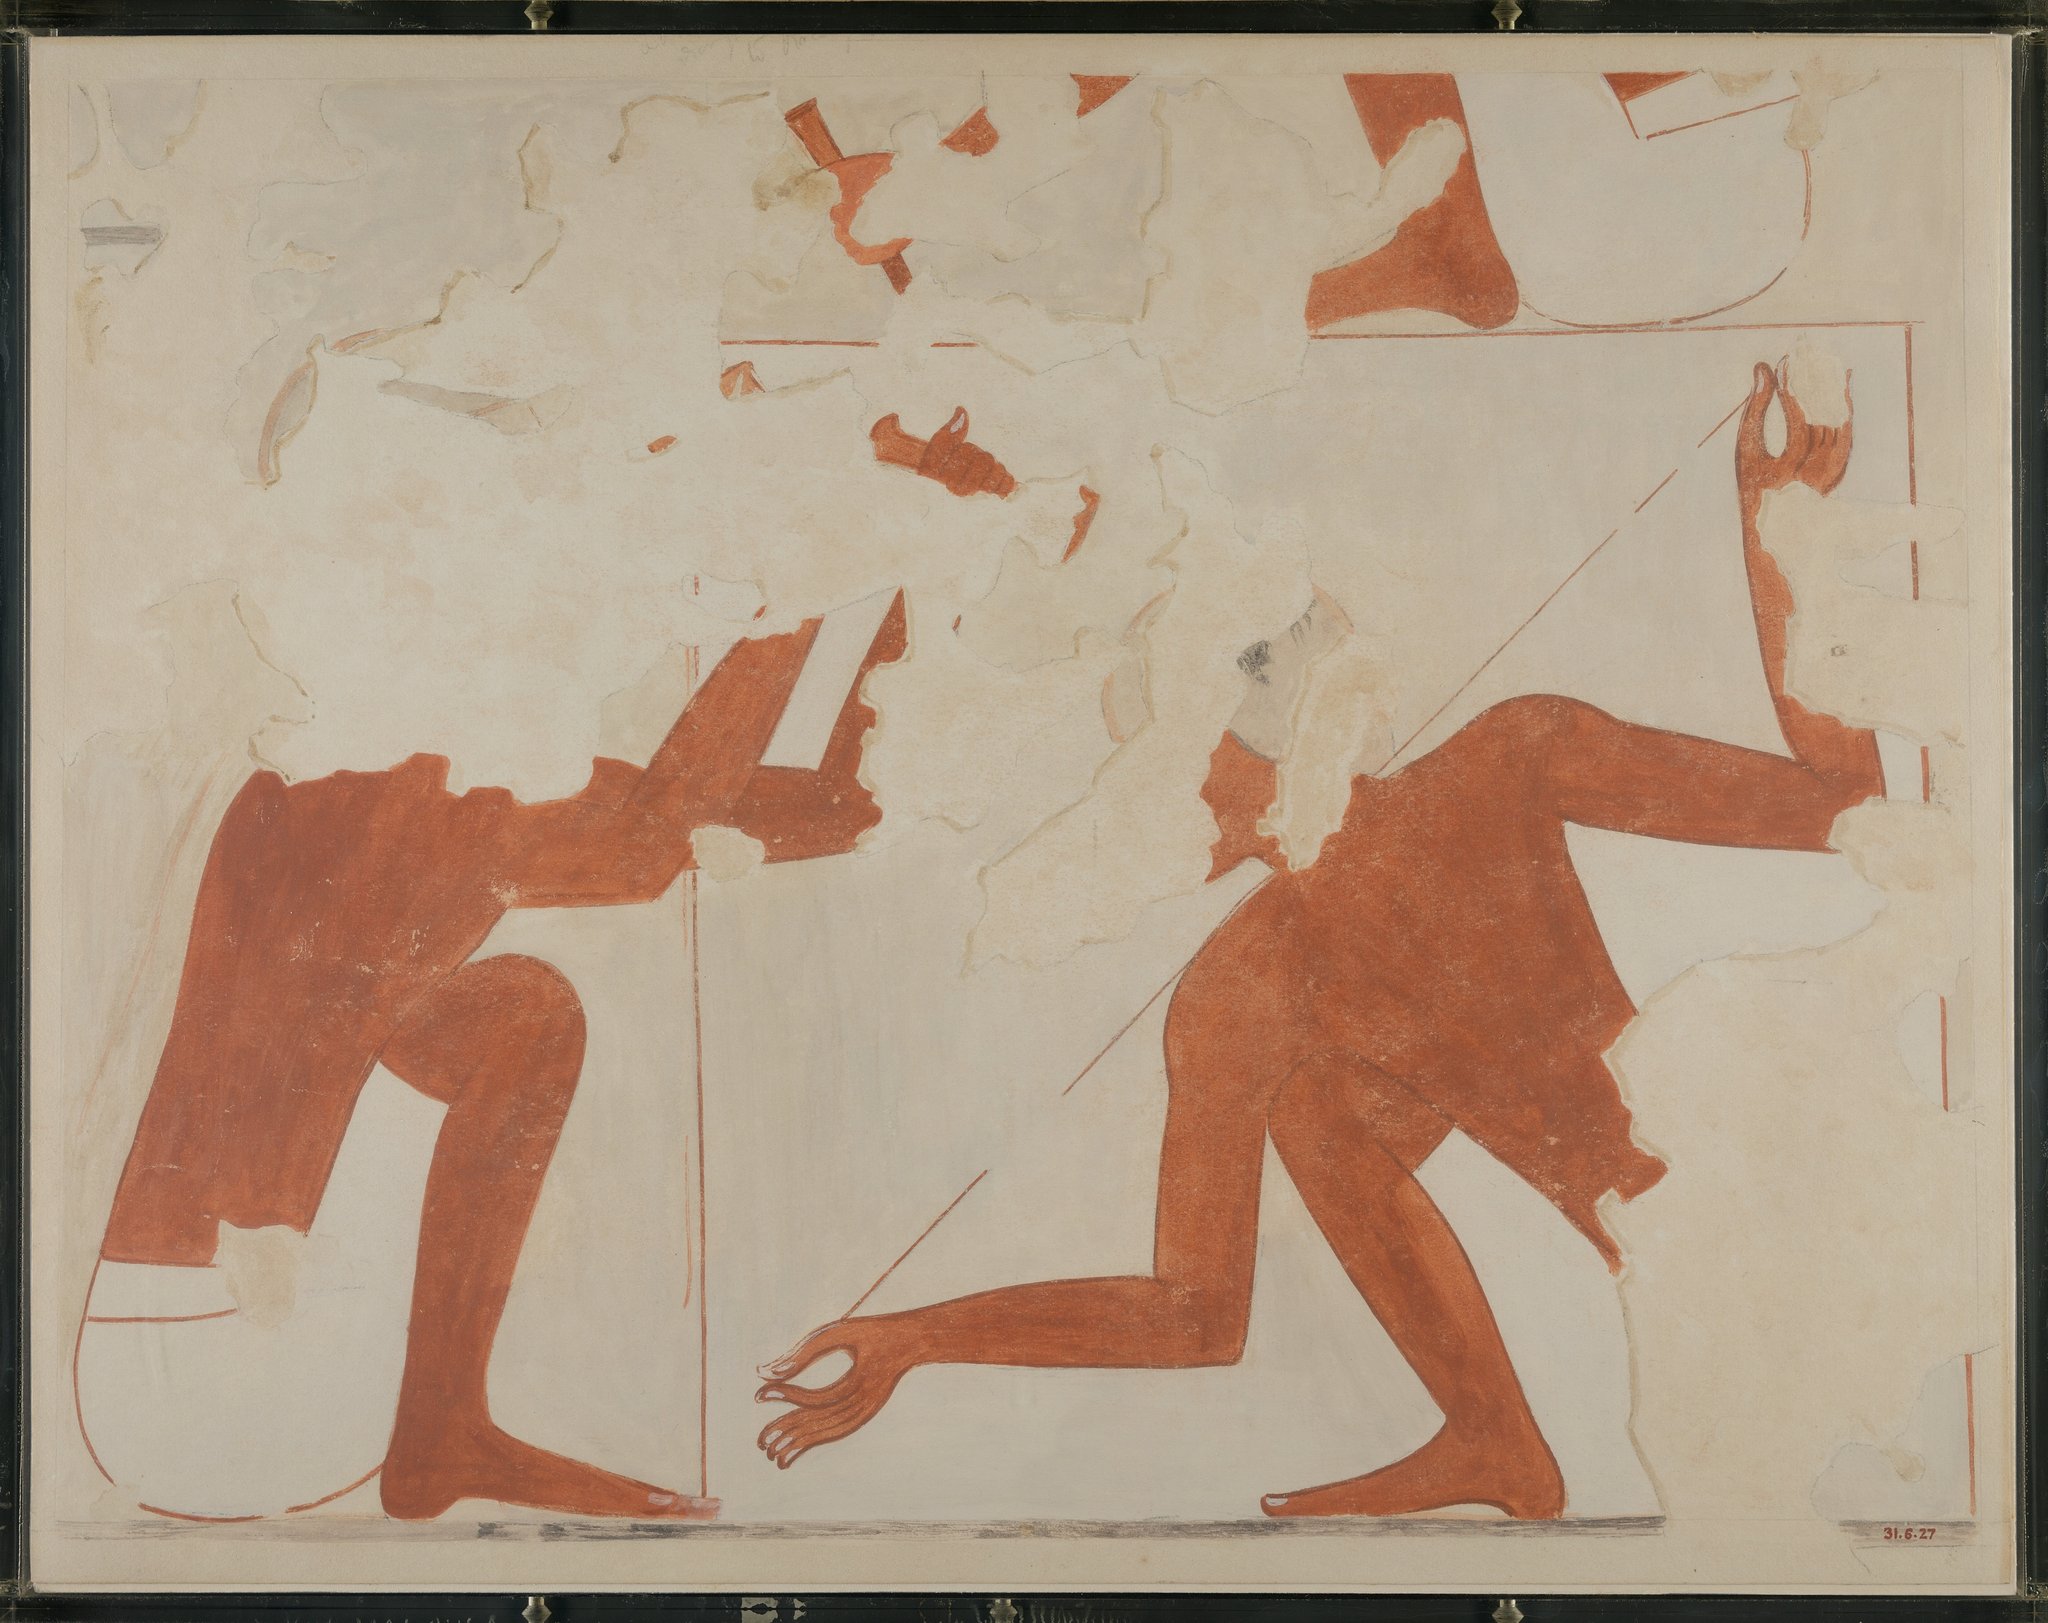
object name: facsimile, rekhmire tt 100, stone mason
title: Stone Masons Sqaring a Block, Tomb of Rekhmire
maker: nina de garis davies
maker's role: artist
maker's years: 1881-1965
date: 1504-1425 BCE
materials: ink, paint, paper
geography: egypt